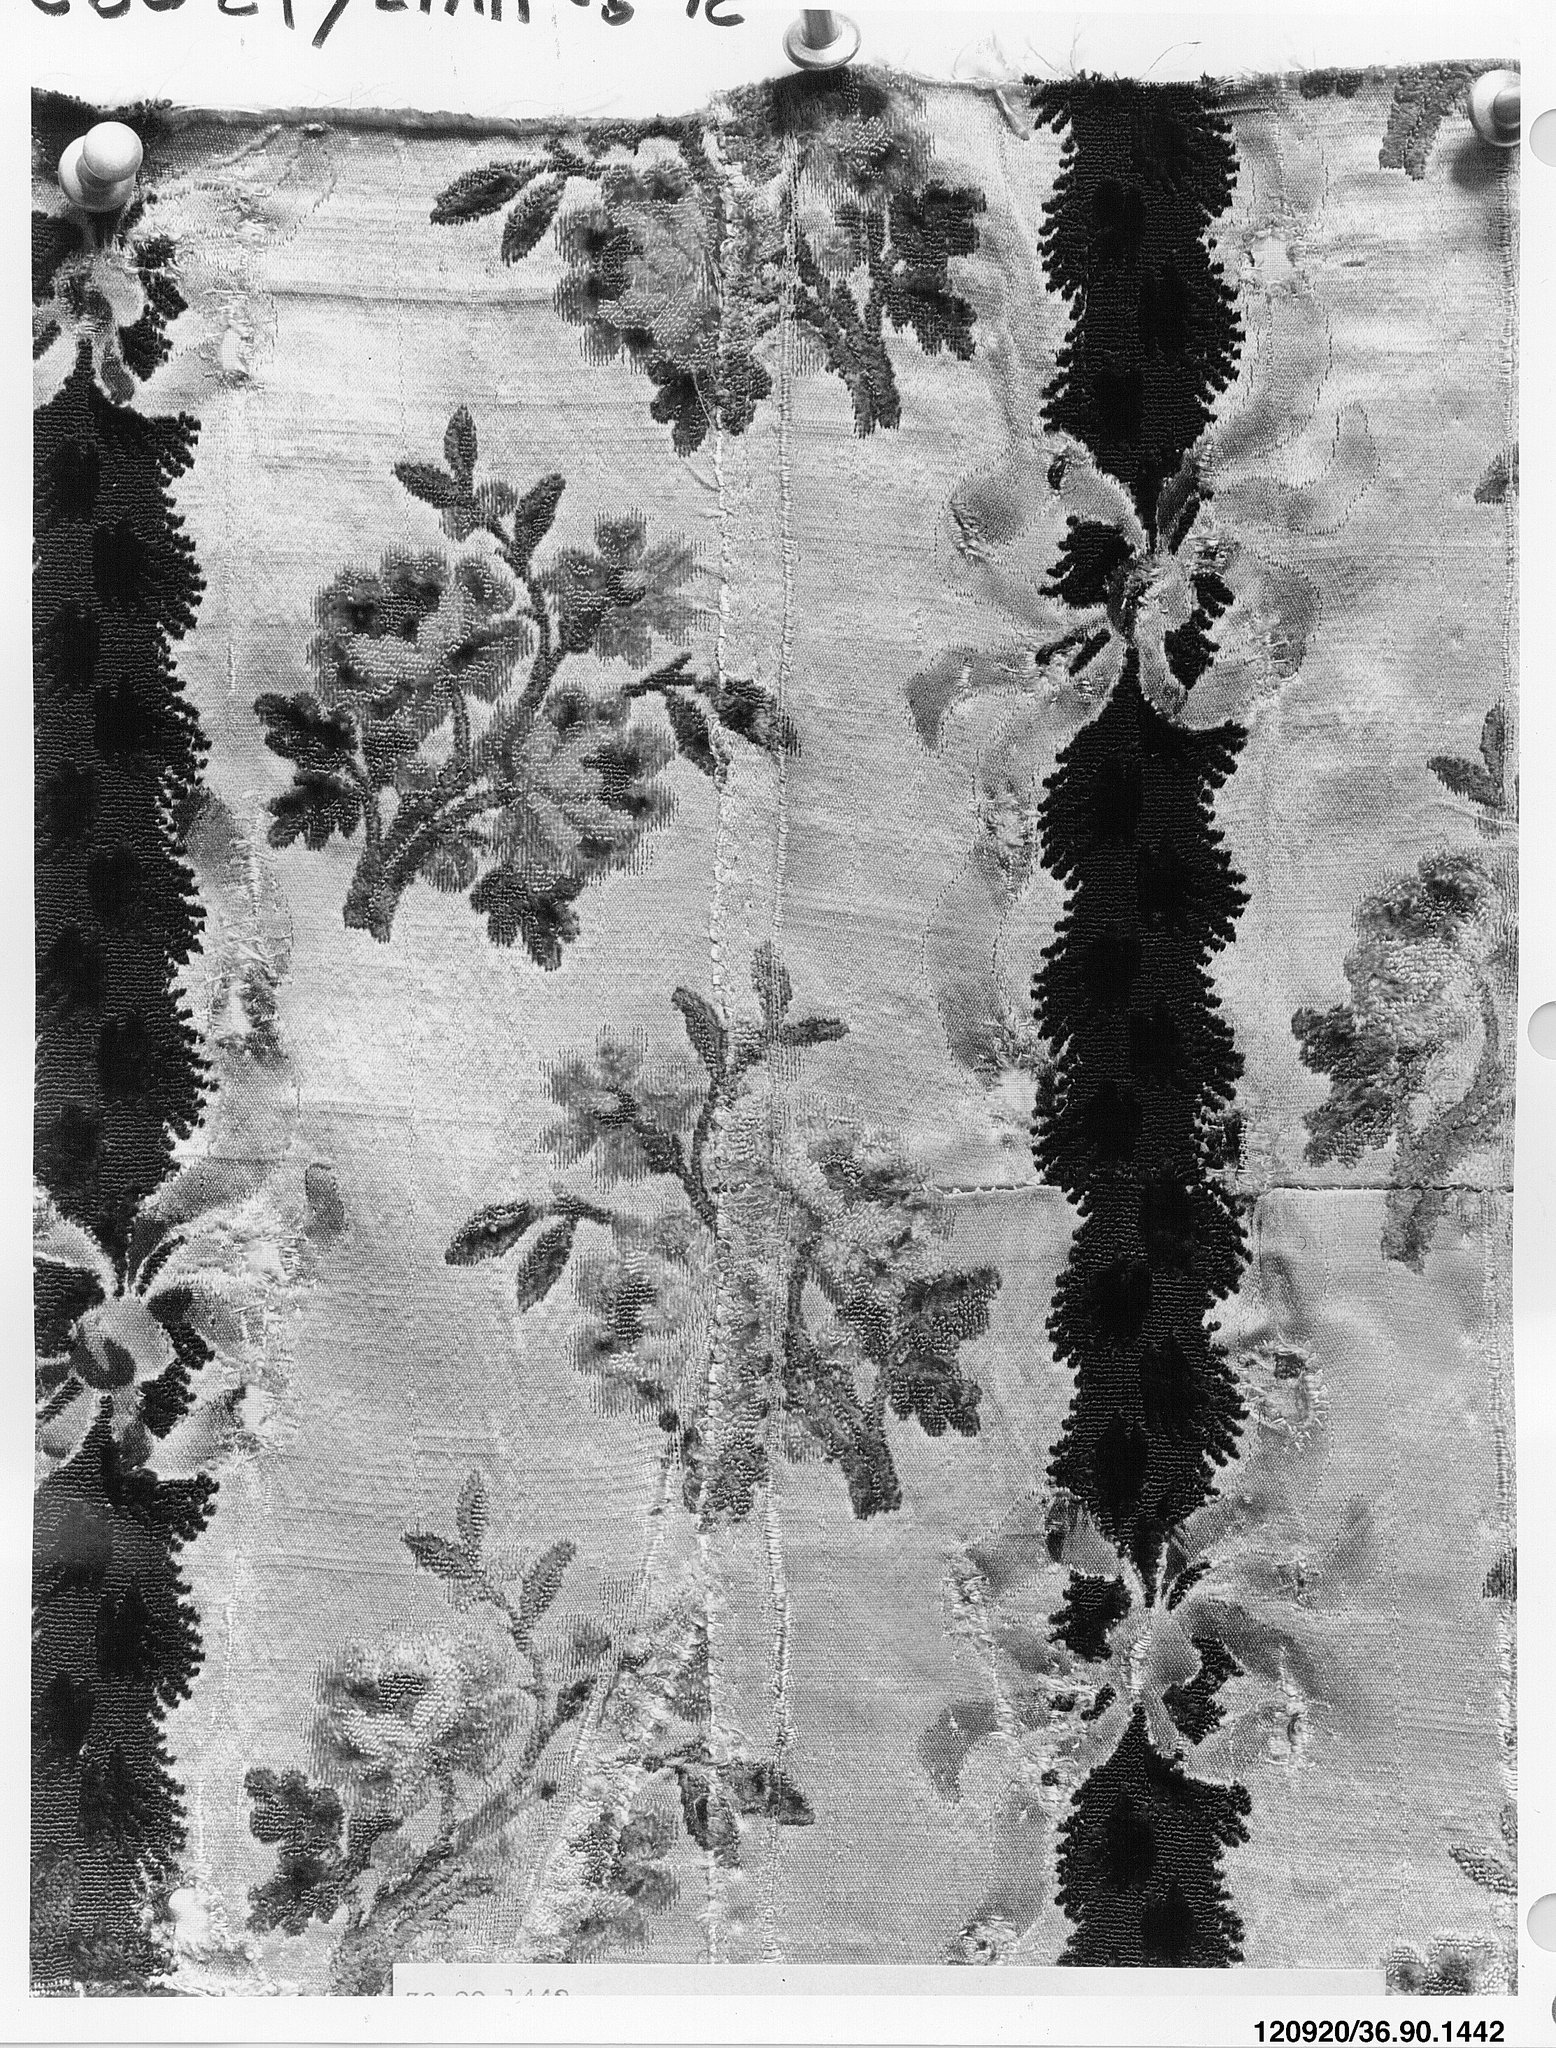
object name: piece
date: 1701-1800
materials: silk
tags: flowers,leaves